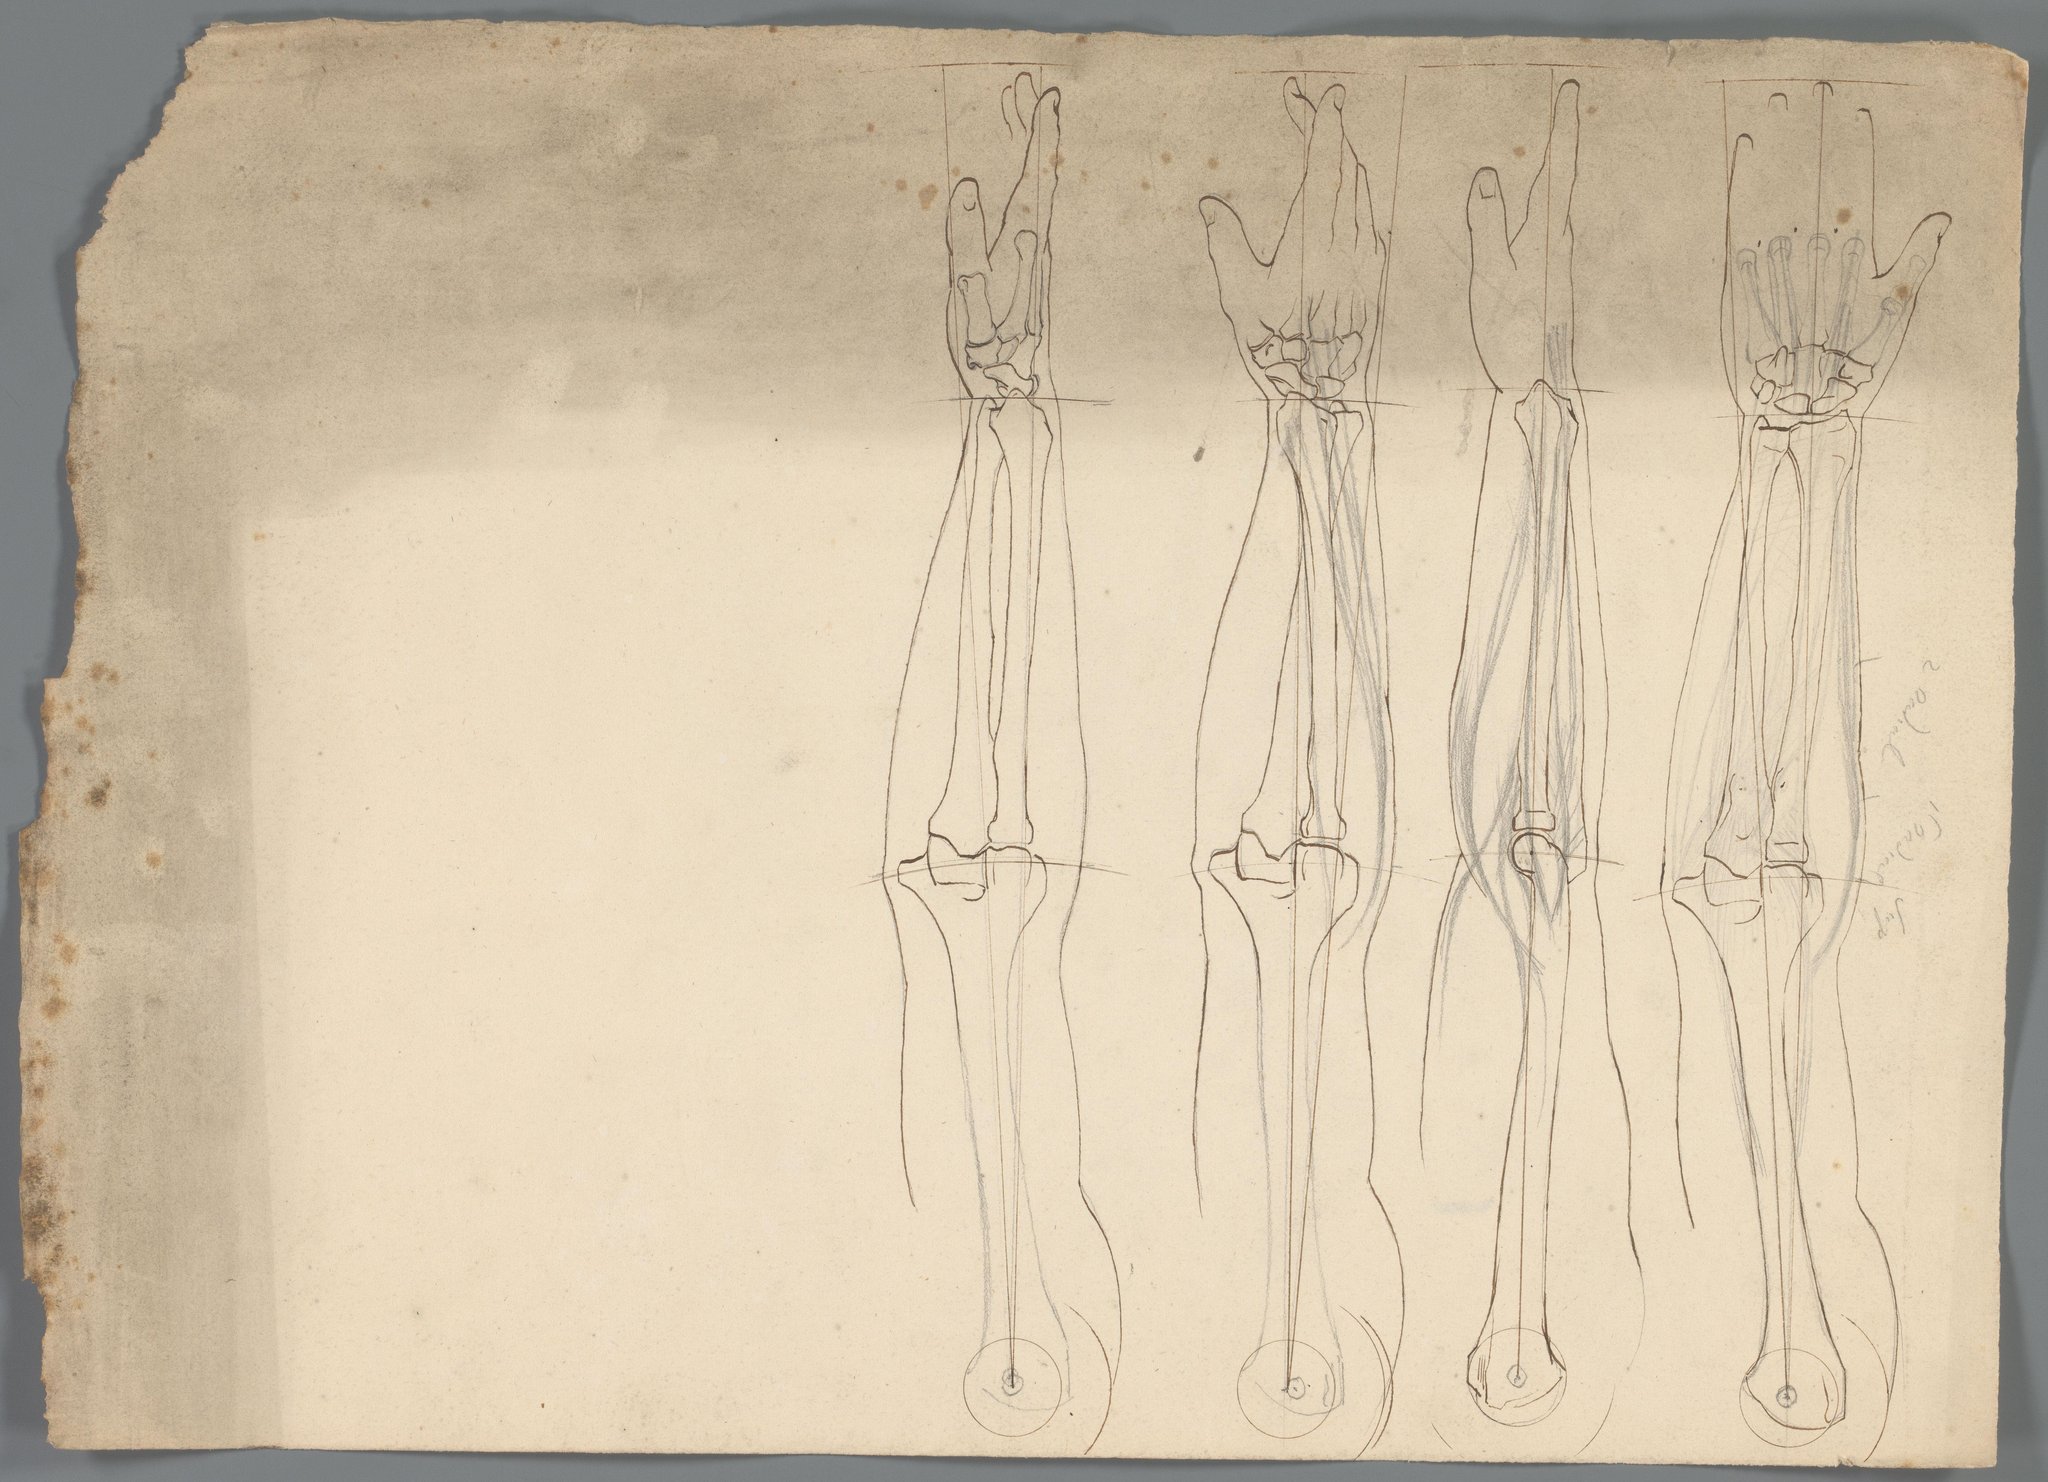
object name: drawing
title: Anatomische studies van een arm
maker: jacobus everhardus josephus van den berg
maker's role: draughtsman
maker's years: 1802-1861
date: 1812-1861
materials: ink, paper, pencil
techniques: pen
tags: arms, bones of the arms